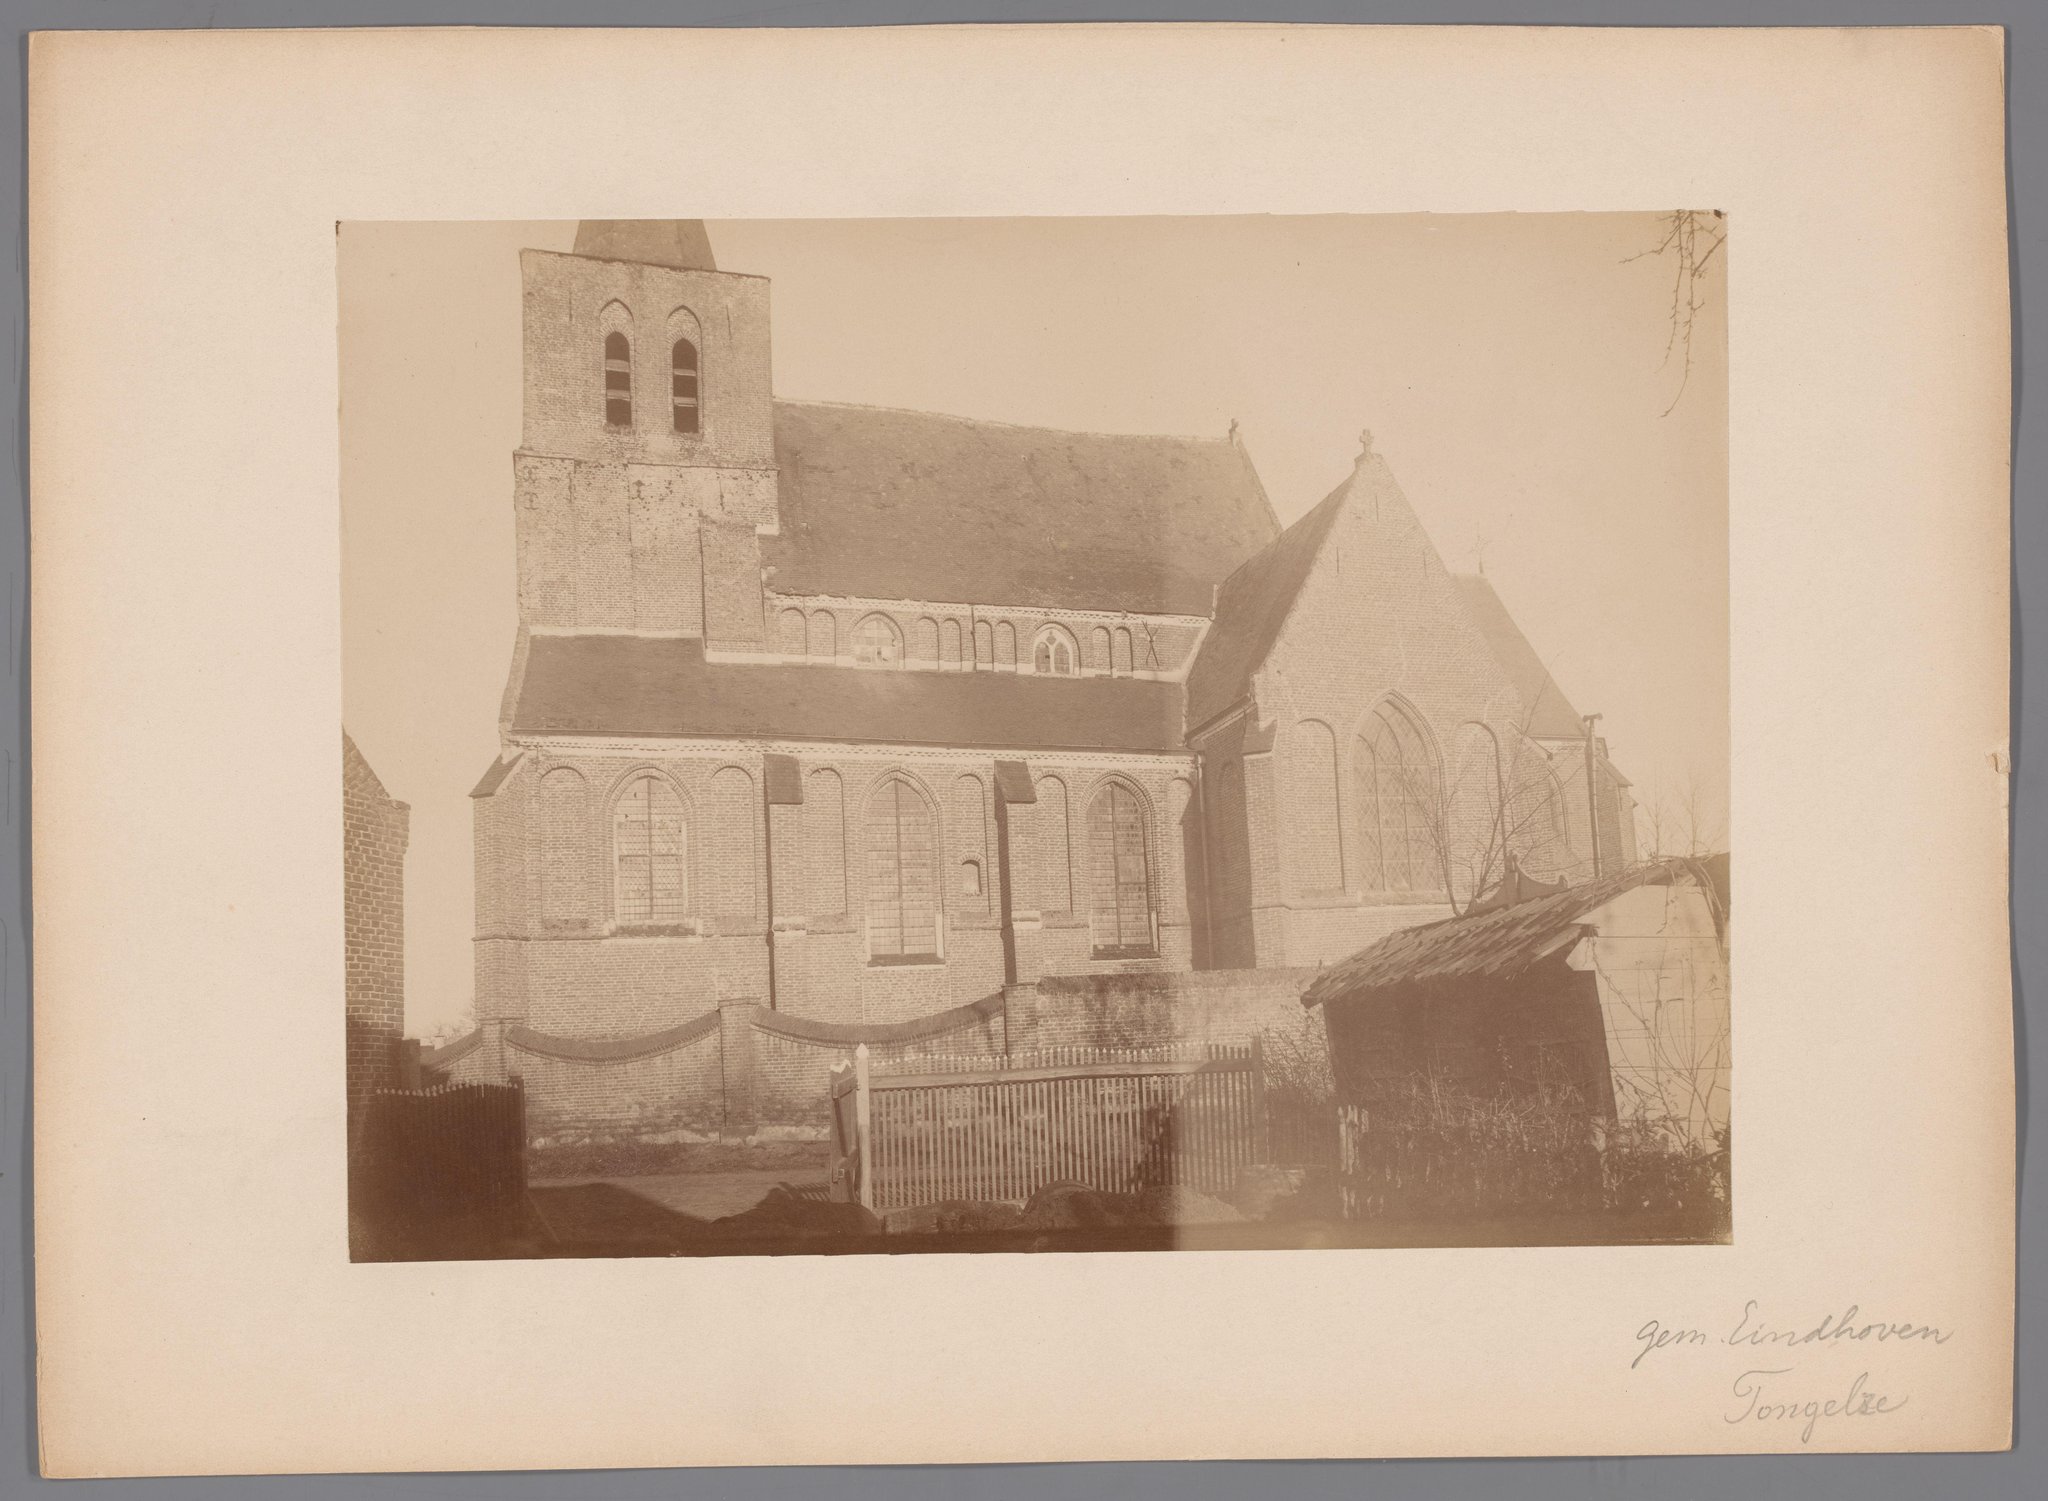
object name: photograph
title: Gezicht op de oude St. Martinuskerk te Tongelre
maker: anoniem (monumentenzorg)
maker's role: fotograaf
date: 1889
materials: cardboard, photographic support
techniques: albumen print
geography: tongelre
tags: church (exterior)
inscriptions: annotation: ‘Gem. Eindhoven/ Tongelre’, annotation: ‘R.K. Kerk te Tongelre 1889’